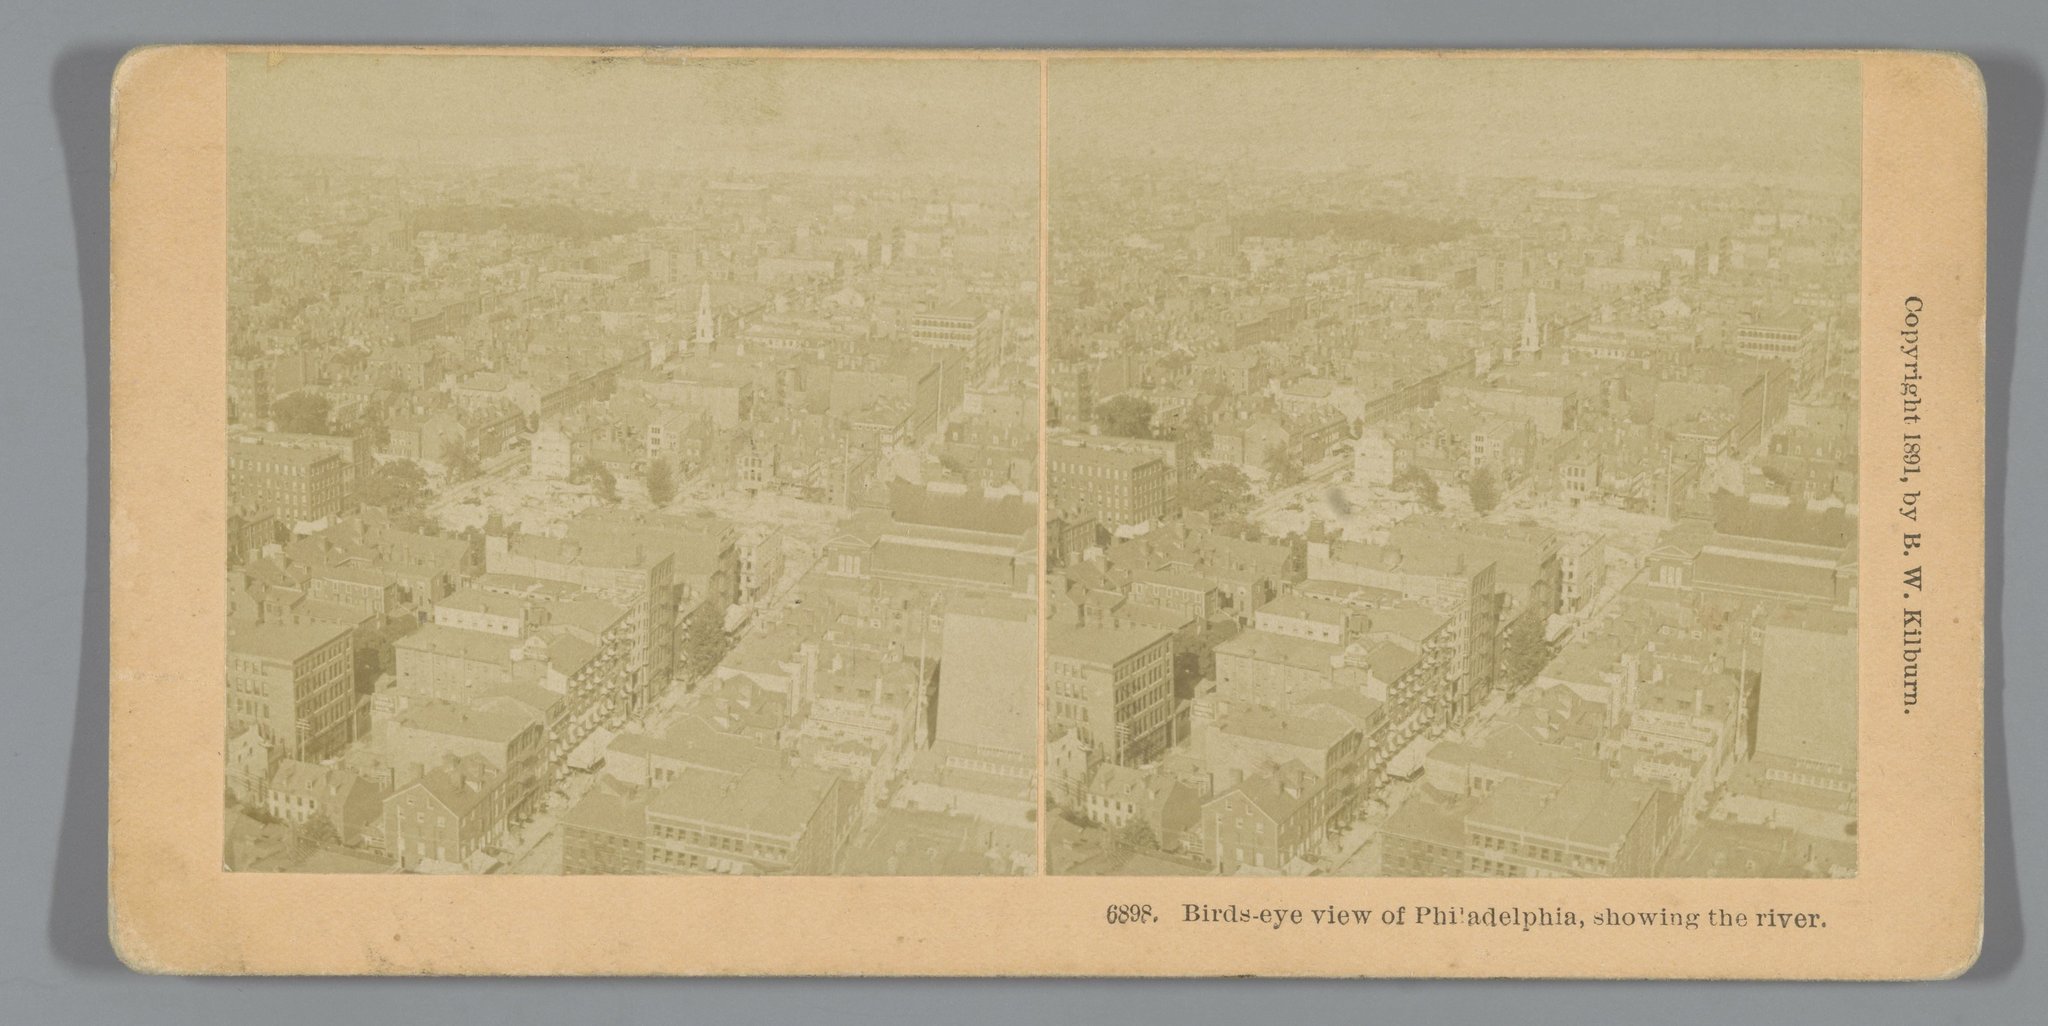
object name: stereograph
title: Birds-eye view of Philadelphia, showing the river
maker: benjamin west kilburn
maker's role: fotograaf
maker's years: 1827-1909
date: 1891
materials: cardboard, paper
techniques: albumen print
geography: littleton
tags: city-view in general; 'veduta'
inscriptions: number: ‘6898’, copyright notice: ‘Copyright 1891, by B. W. Kilburn.’